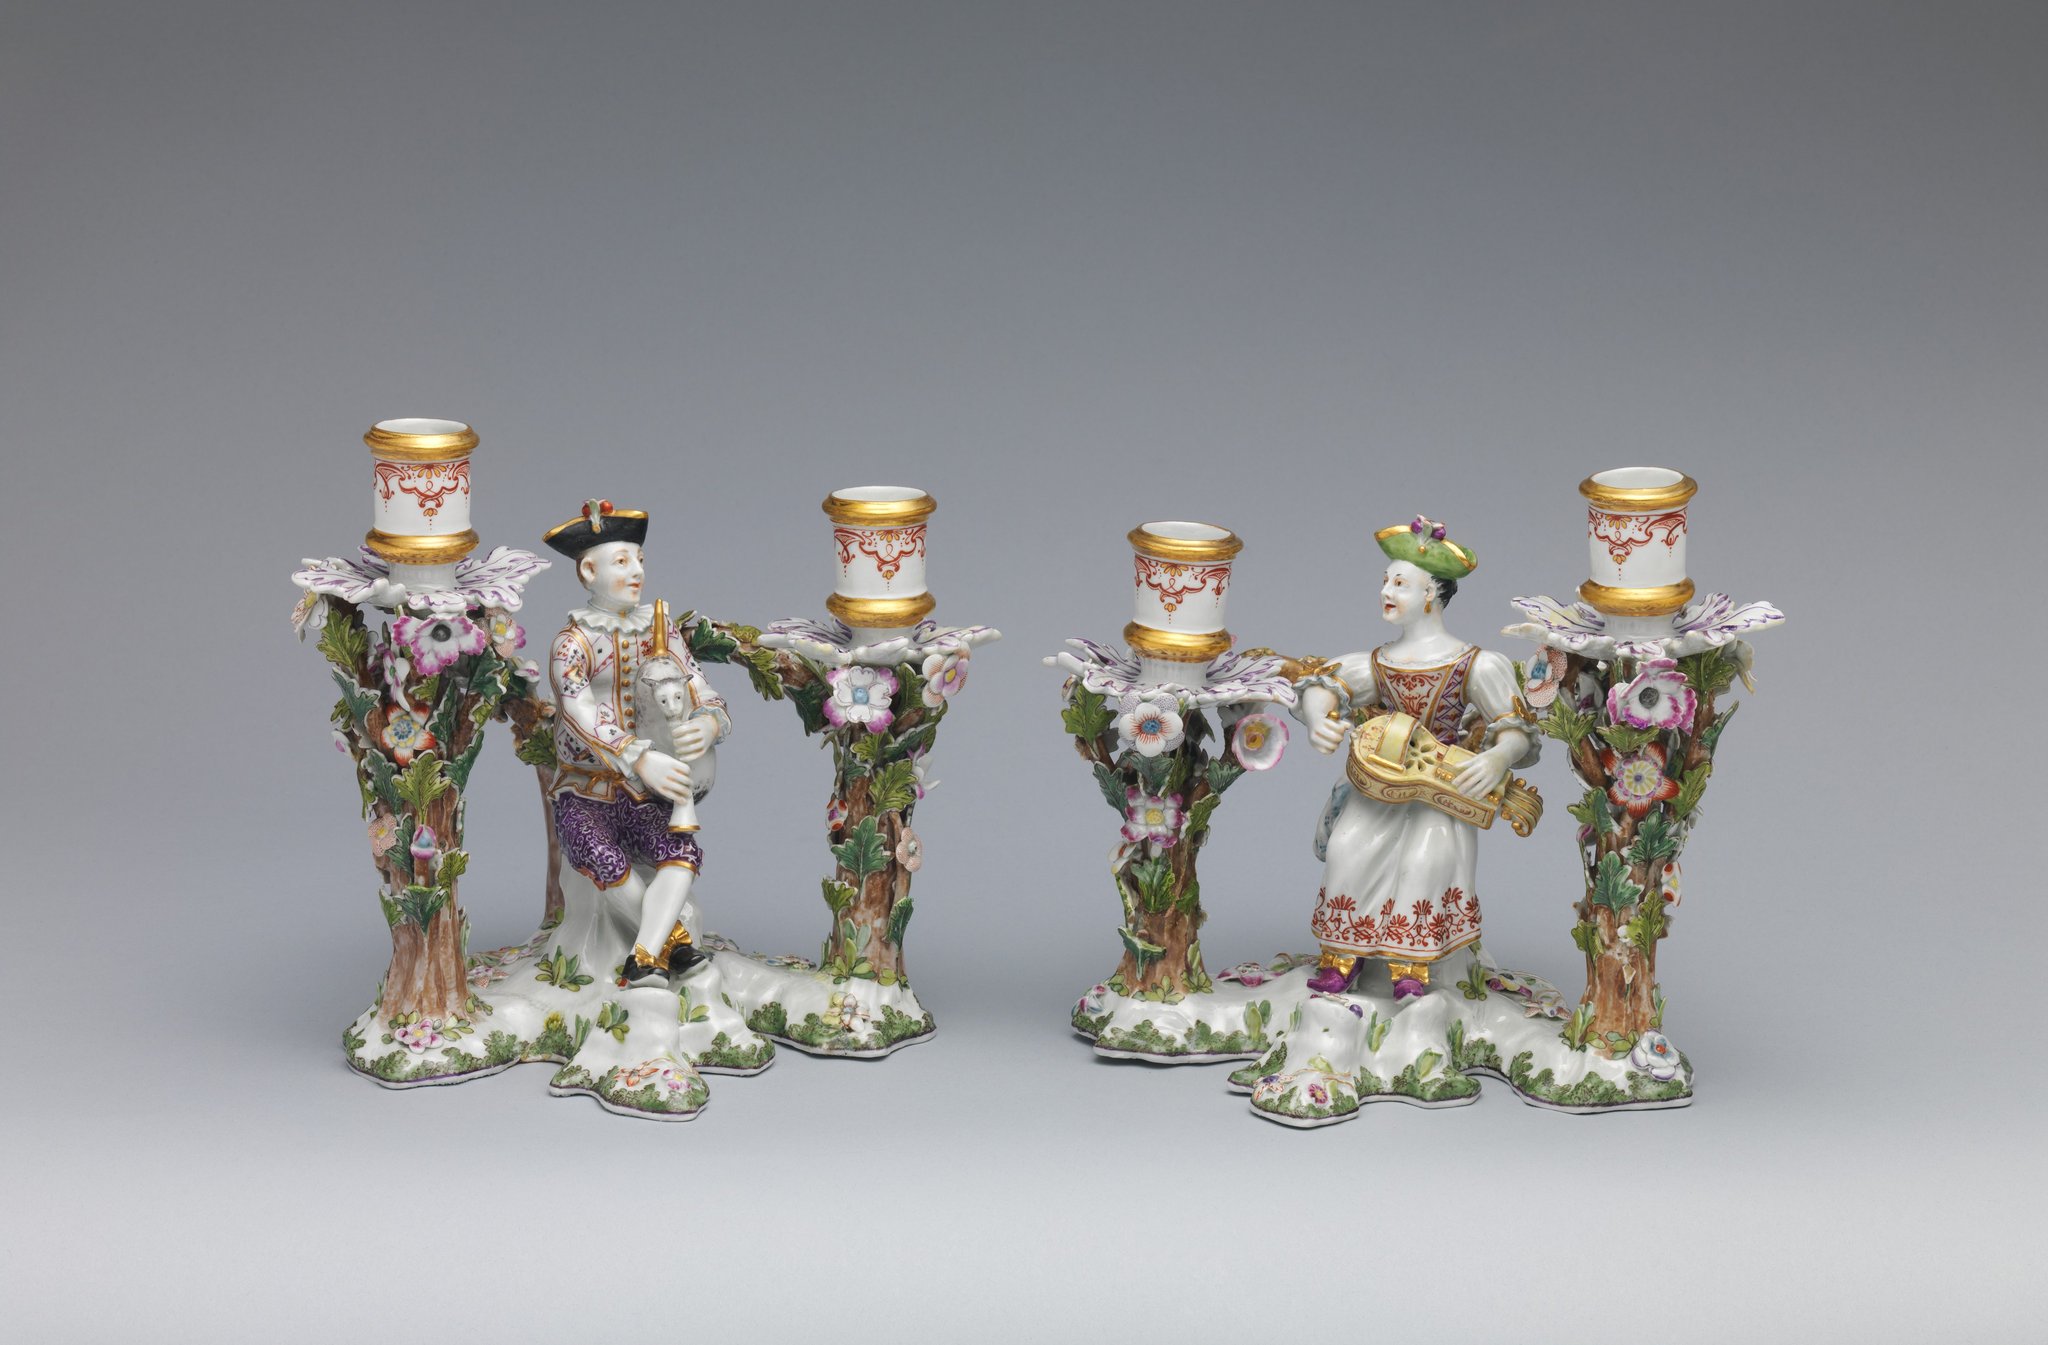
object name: candelabrum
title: Candelabrum (one of a pair)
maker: vienna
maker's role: manufactory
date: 1740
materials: hard paste porcelain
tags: musical instruments,men,women,musicians